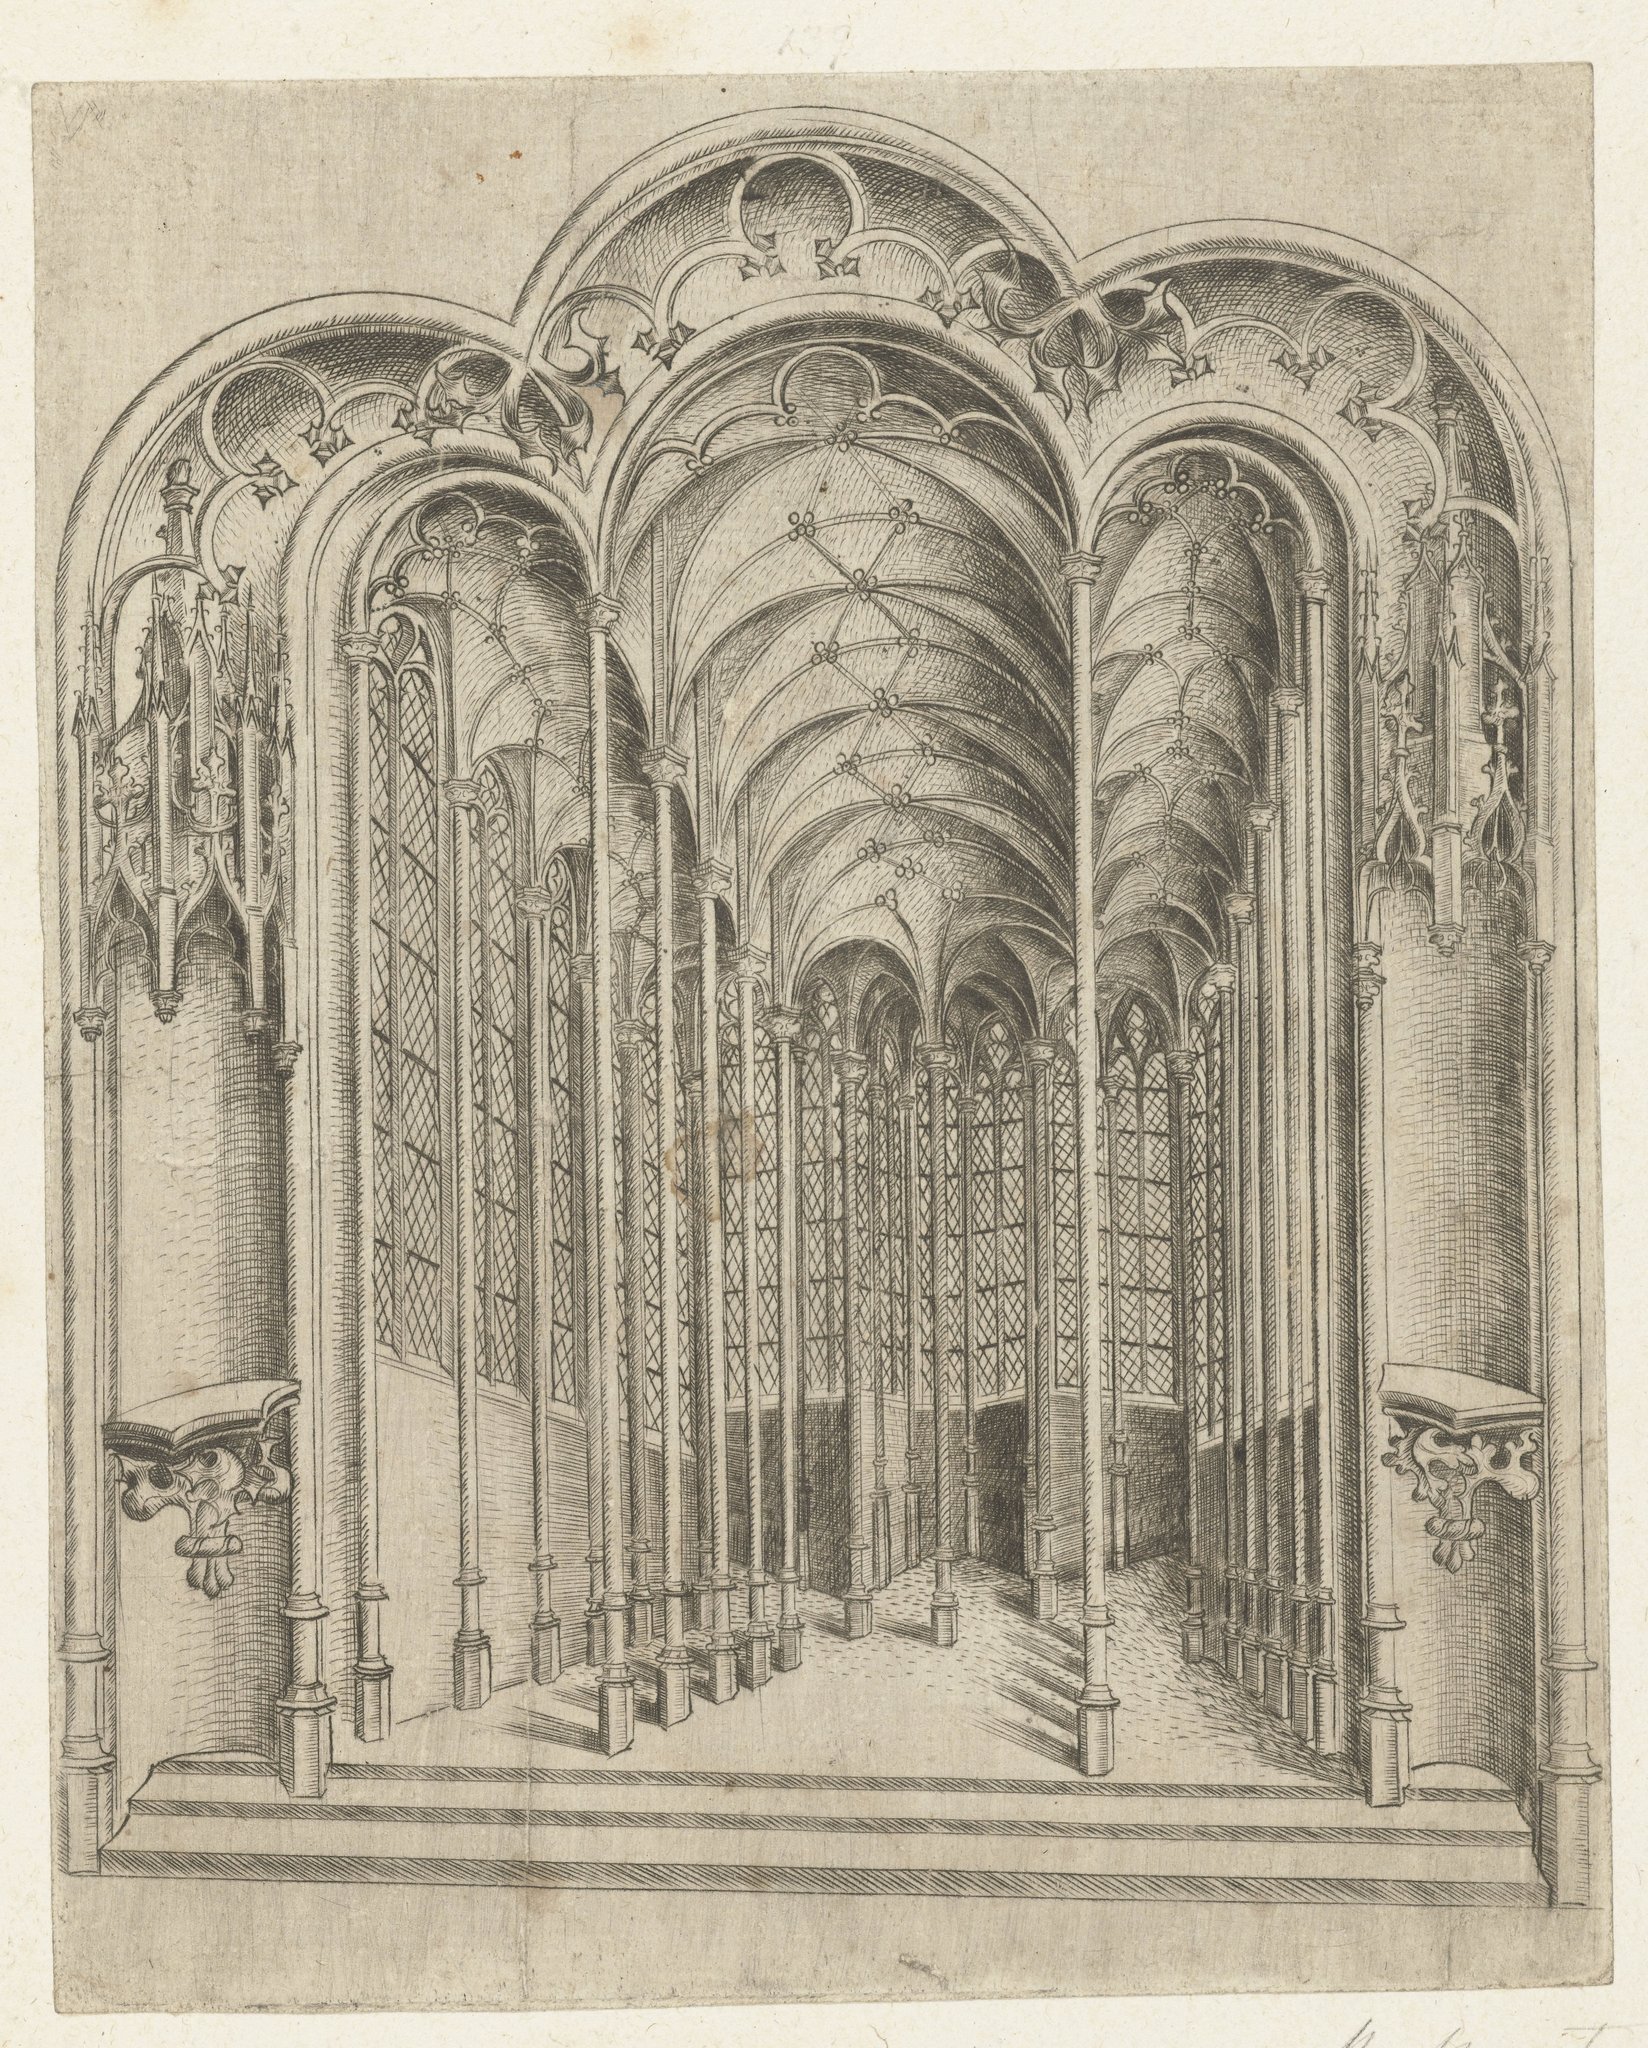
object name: print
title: A Gothic Church Interior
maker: monogrammist wa met de sleutel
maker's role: print maker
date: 1490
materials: paper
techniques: engraving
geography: low countries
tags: interior of church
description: Although the printmaker was unfamiliar with geometrical perspective, he nevertheless succeeded in creating a convincing illusion of space. Here he tried out all kinds of tactics: an asymmetrical vantage point from a diagonally placed threshold, receding colonnades, and the effect of the cast shadows. The sheet could thus serve as a model for painters, sculptors, and cabinetmakers.